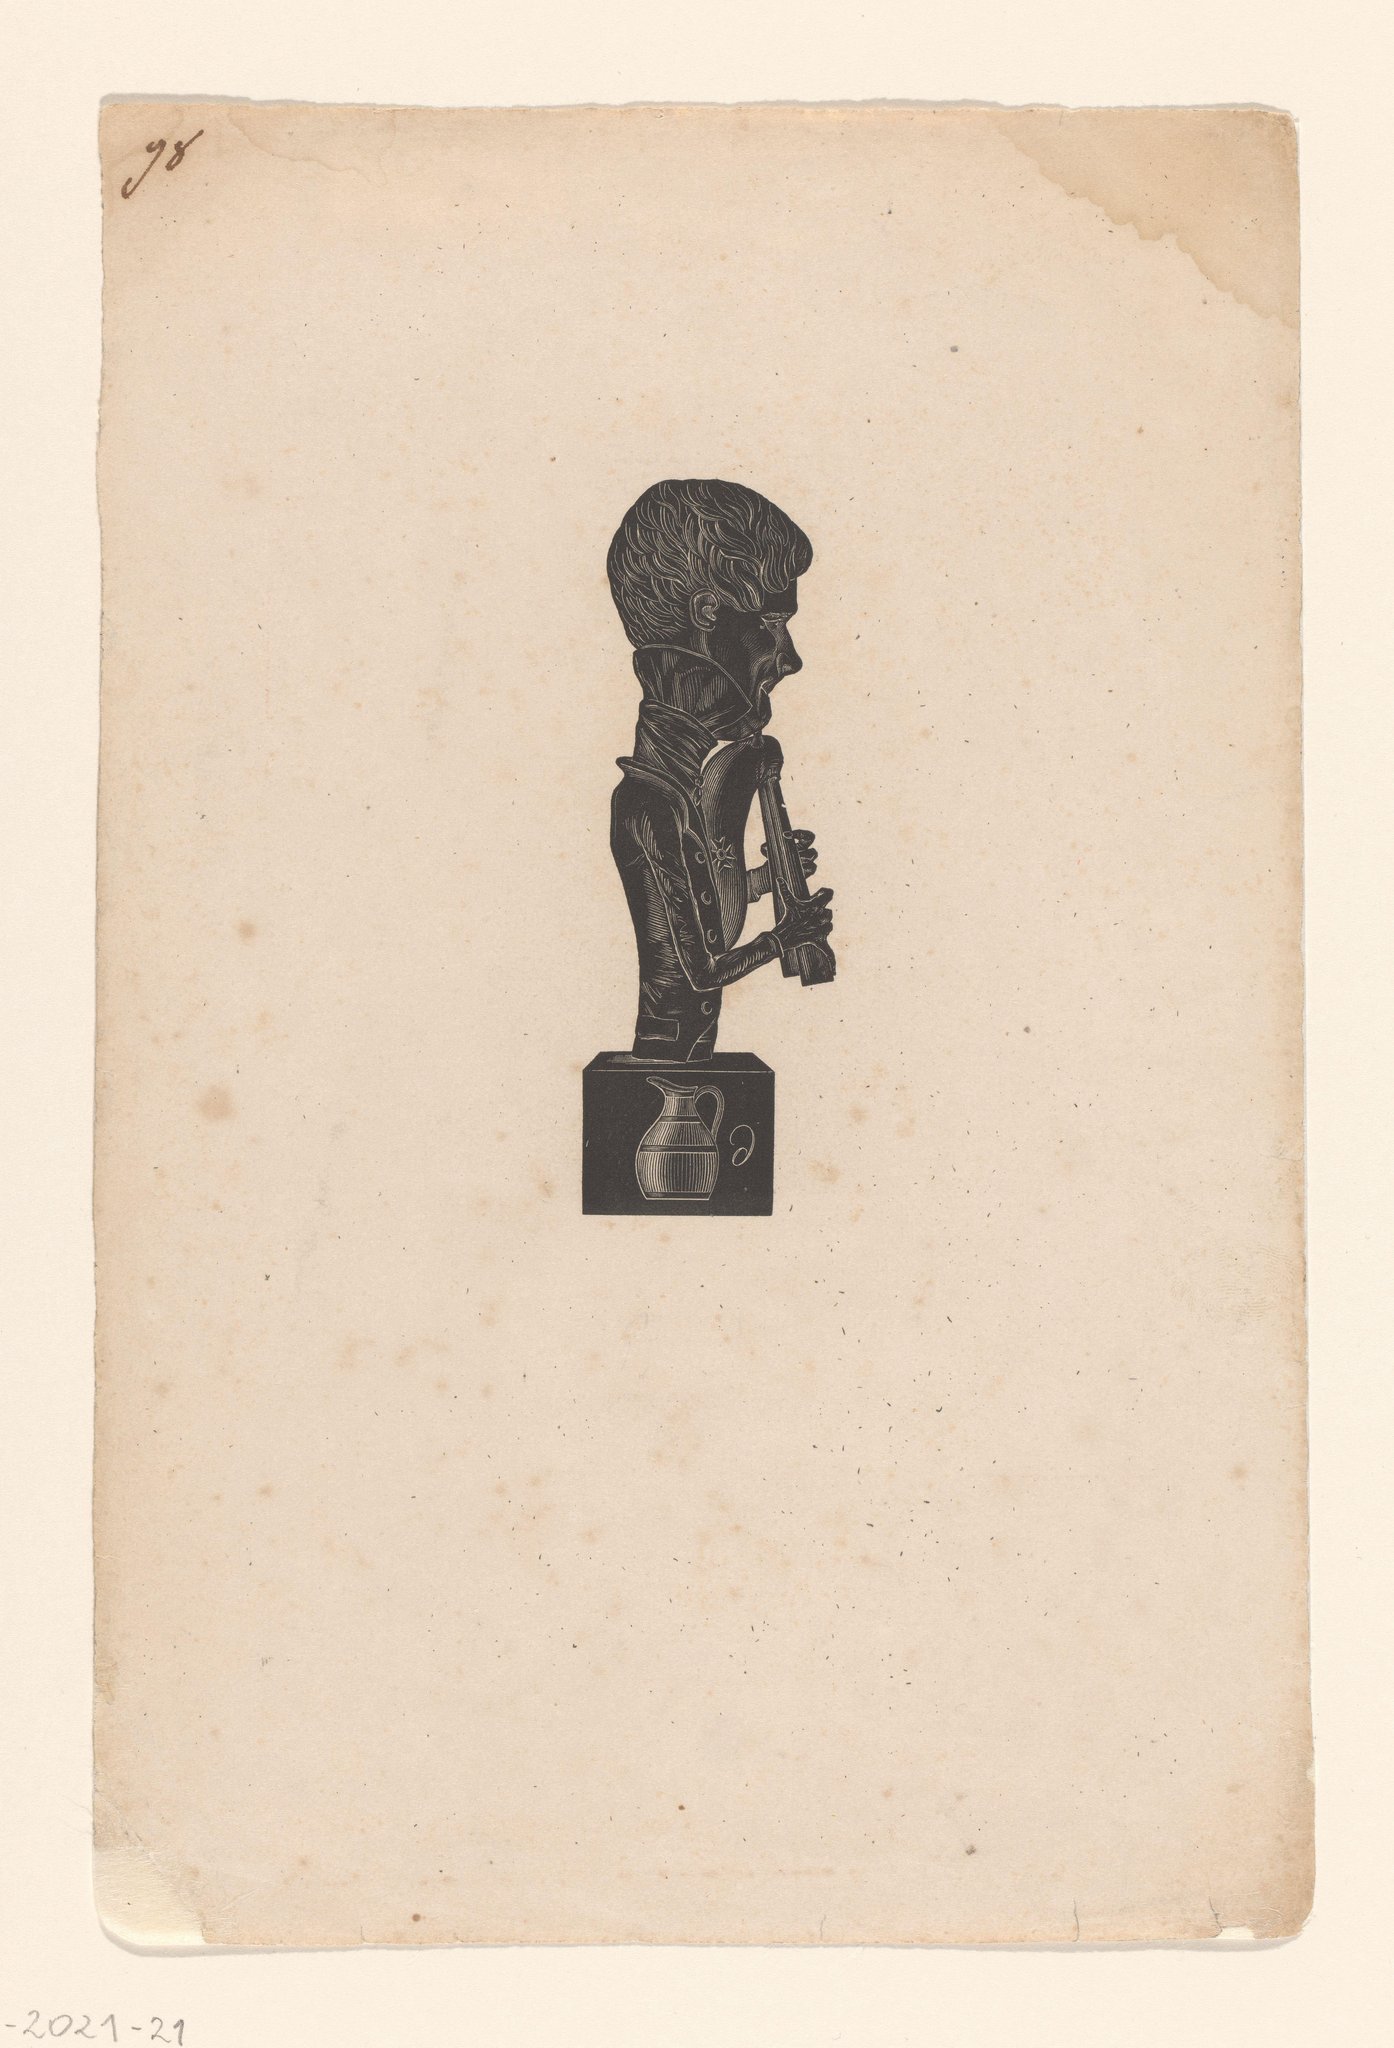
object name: print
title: Karikaturaal portret van Henri Brod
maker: théodore maurisset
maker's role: painter, print maker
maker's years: 1803-1860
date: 1839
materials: paper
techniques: woodcut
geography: paris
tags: henri brod, caricatures (human types), one person playing wind instrument, historical persons, portrait of a musician, portrait, self-portrait of artist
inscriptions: collector's mark: Lugt 2228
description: Karikatuur van de Franse hoboïst en hobobouwer Henri Brod. De prent behoort tot een serie van 100 houtsneden door Théodore Maurisset (actief 1834-1859) naar Jean Pierre Dantan's karikatuurbustes van Franse beroemdheden uit 'Musée Dantan. Galerie des Charges et Croquis des célébrités de l'époque, avec texte explicatif et biographique' (Parijs, 1839). In de karikatuur wordt Brod afgebeeld terwijl hij doedelzak speelt, een houtblaasinstrument dat, net als de hobo, een riet heeft maar van een meer volkse oorsprong is.